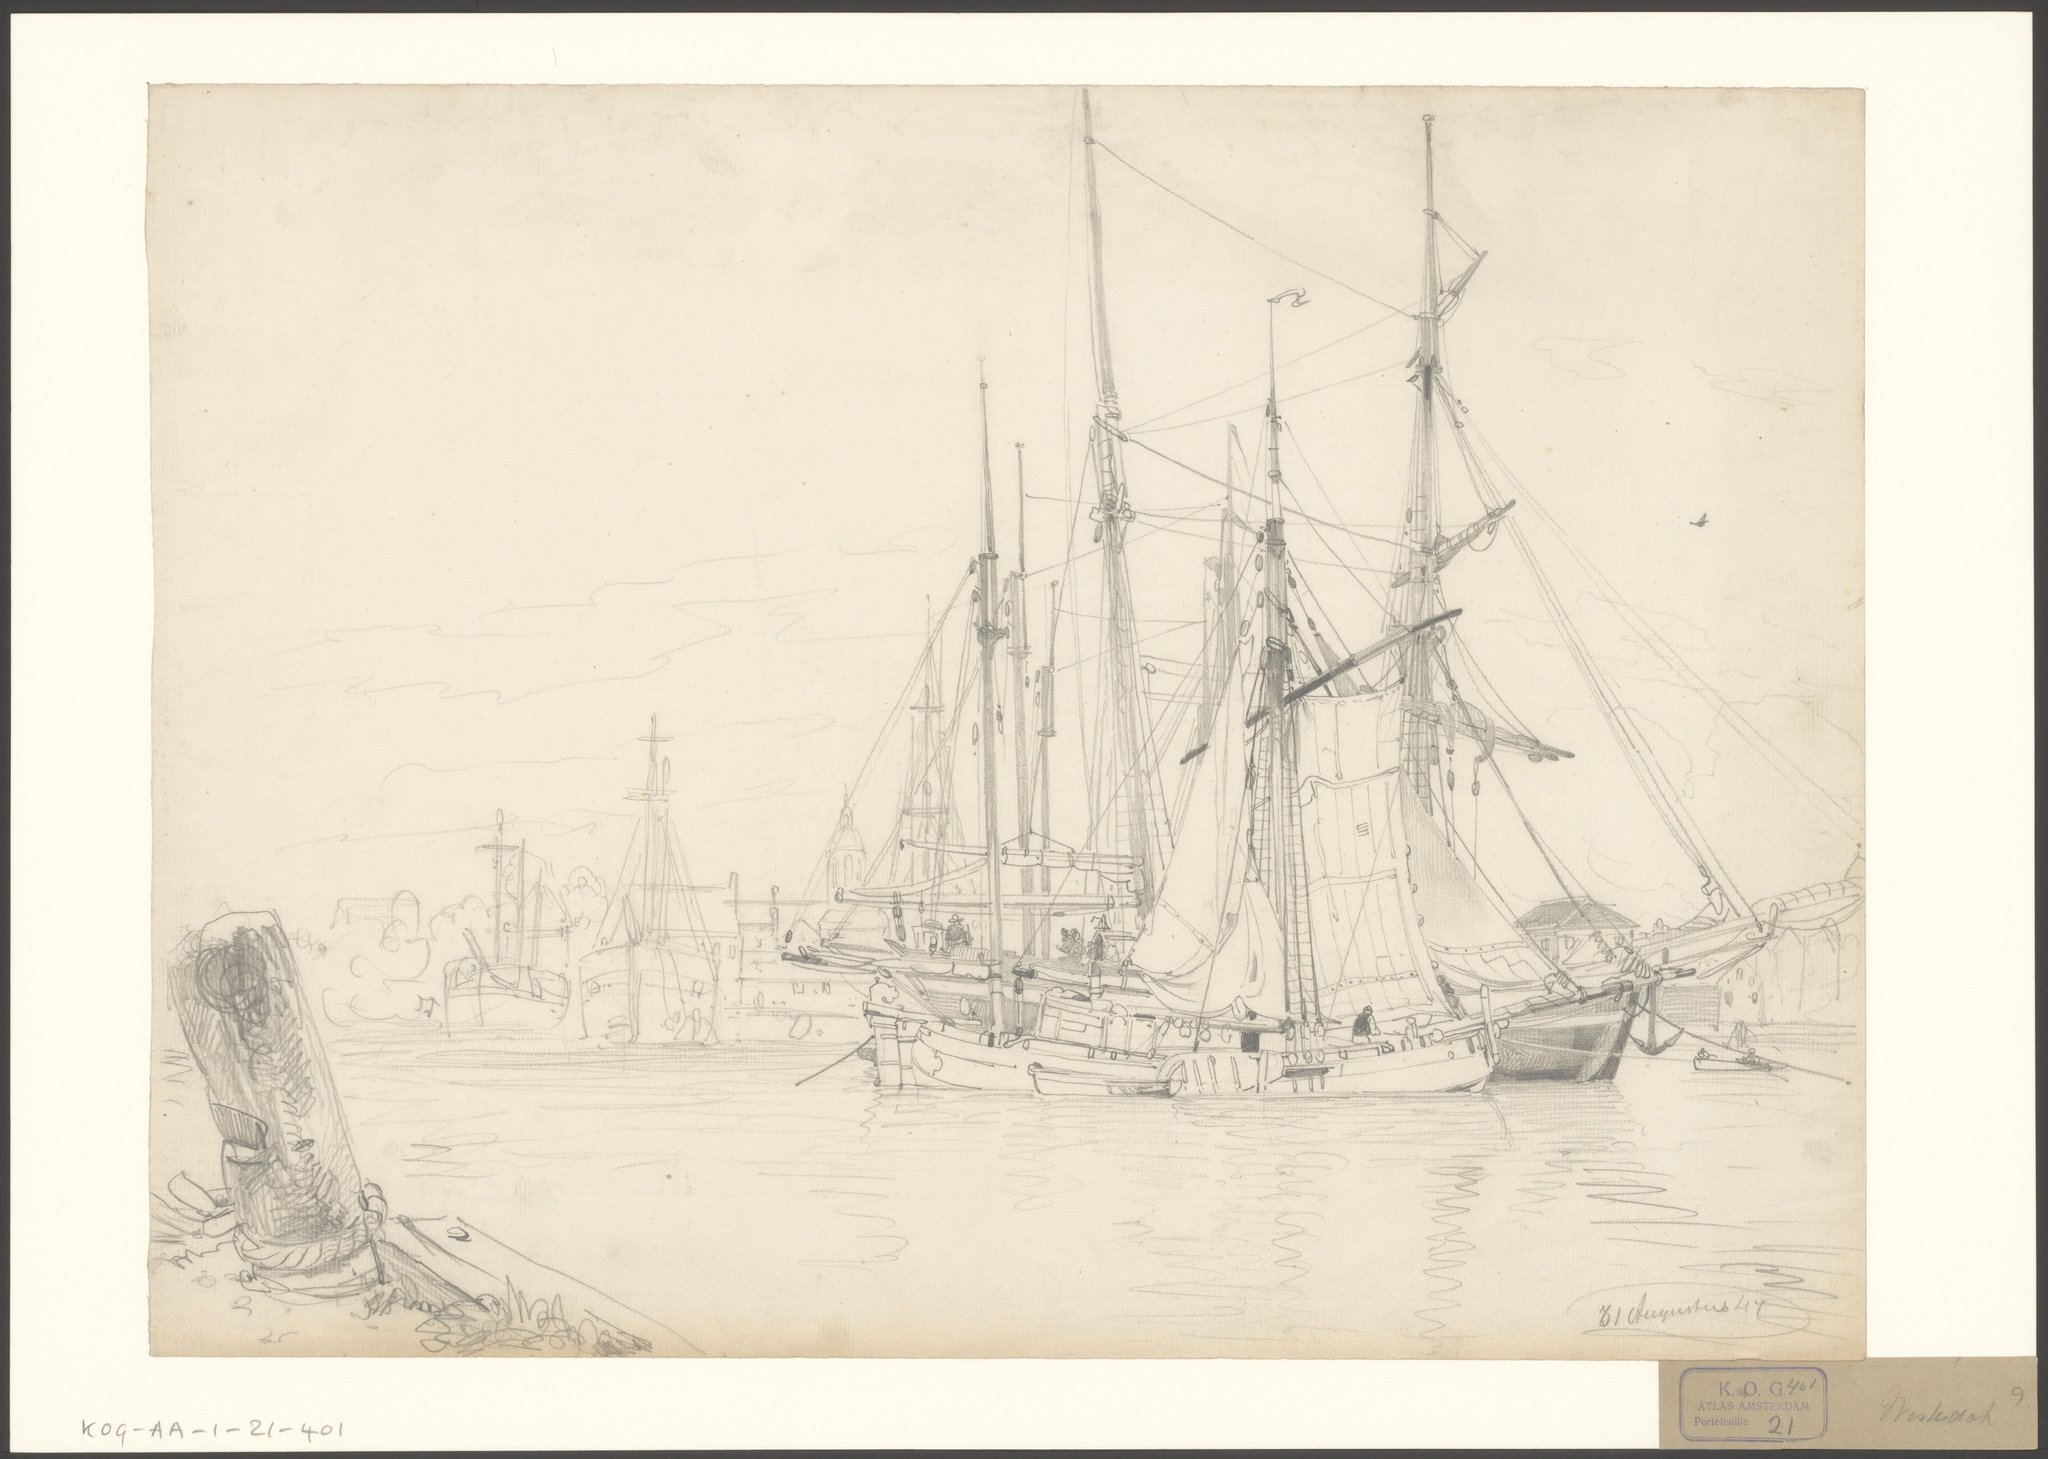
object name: drawing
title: Gezicht op schepen in het Westerdok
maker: willem anthonie van deventer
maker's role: draughtsman, painter, print maker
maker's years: 1824-1893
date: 1847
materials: paper, pencil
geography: amsterdam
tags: sailing-ship, sailing-boat, city-view in general; 'veduta', river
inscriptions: date: ‘31 Augustus 47’, inscription: ‘Port. 21 - 401’, collector's mark: ‘21’ Lugt 1641b, inscription: ‘Westerdok? / door W.A. van Deventer’